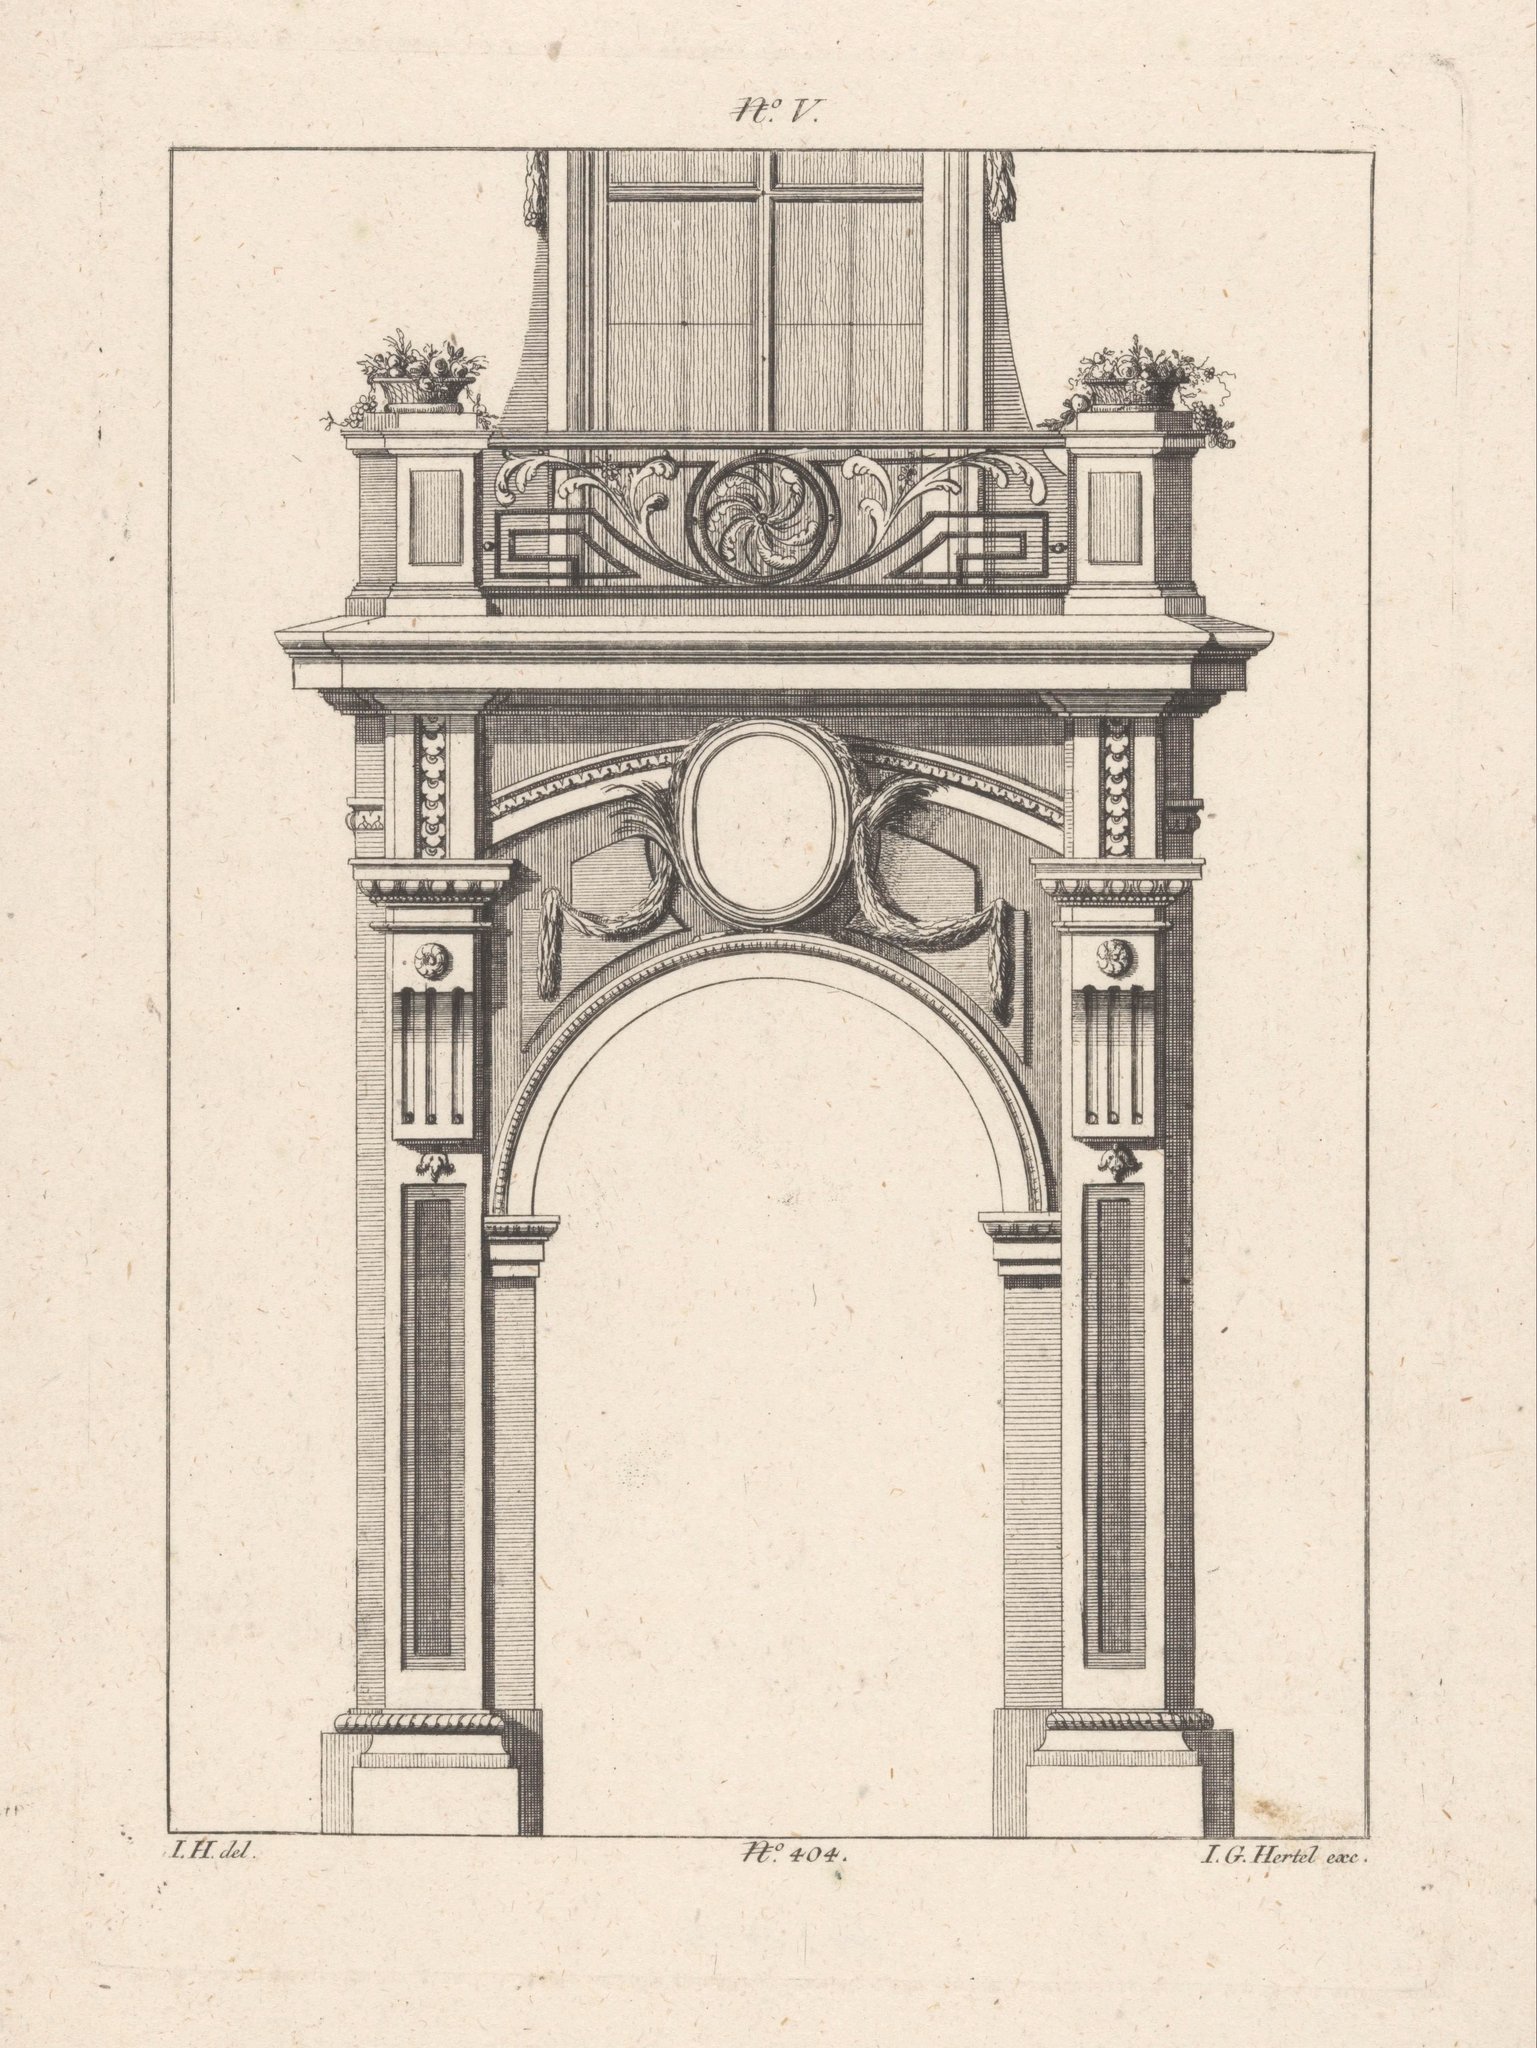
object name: ornament print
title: Portalen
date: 1770-1788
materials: paper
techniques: engraving, etching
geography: augsburg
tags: monumental door, porch, 'aediculum', ornament ~ medallion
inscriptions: collector's mark: Lugt 2228, collector's mark: Lugt 2760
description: Ontwerp voor een portaal met ovaal medaillon en guirlandes. Daarboven twee manden met bloemen aan weerszijden van een hekwerk. Uitgeversnummer 404.